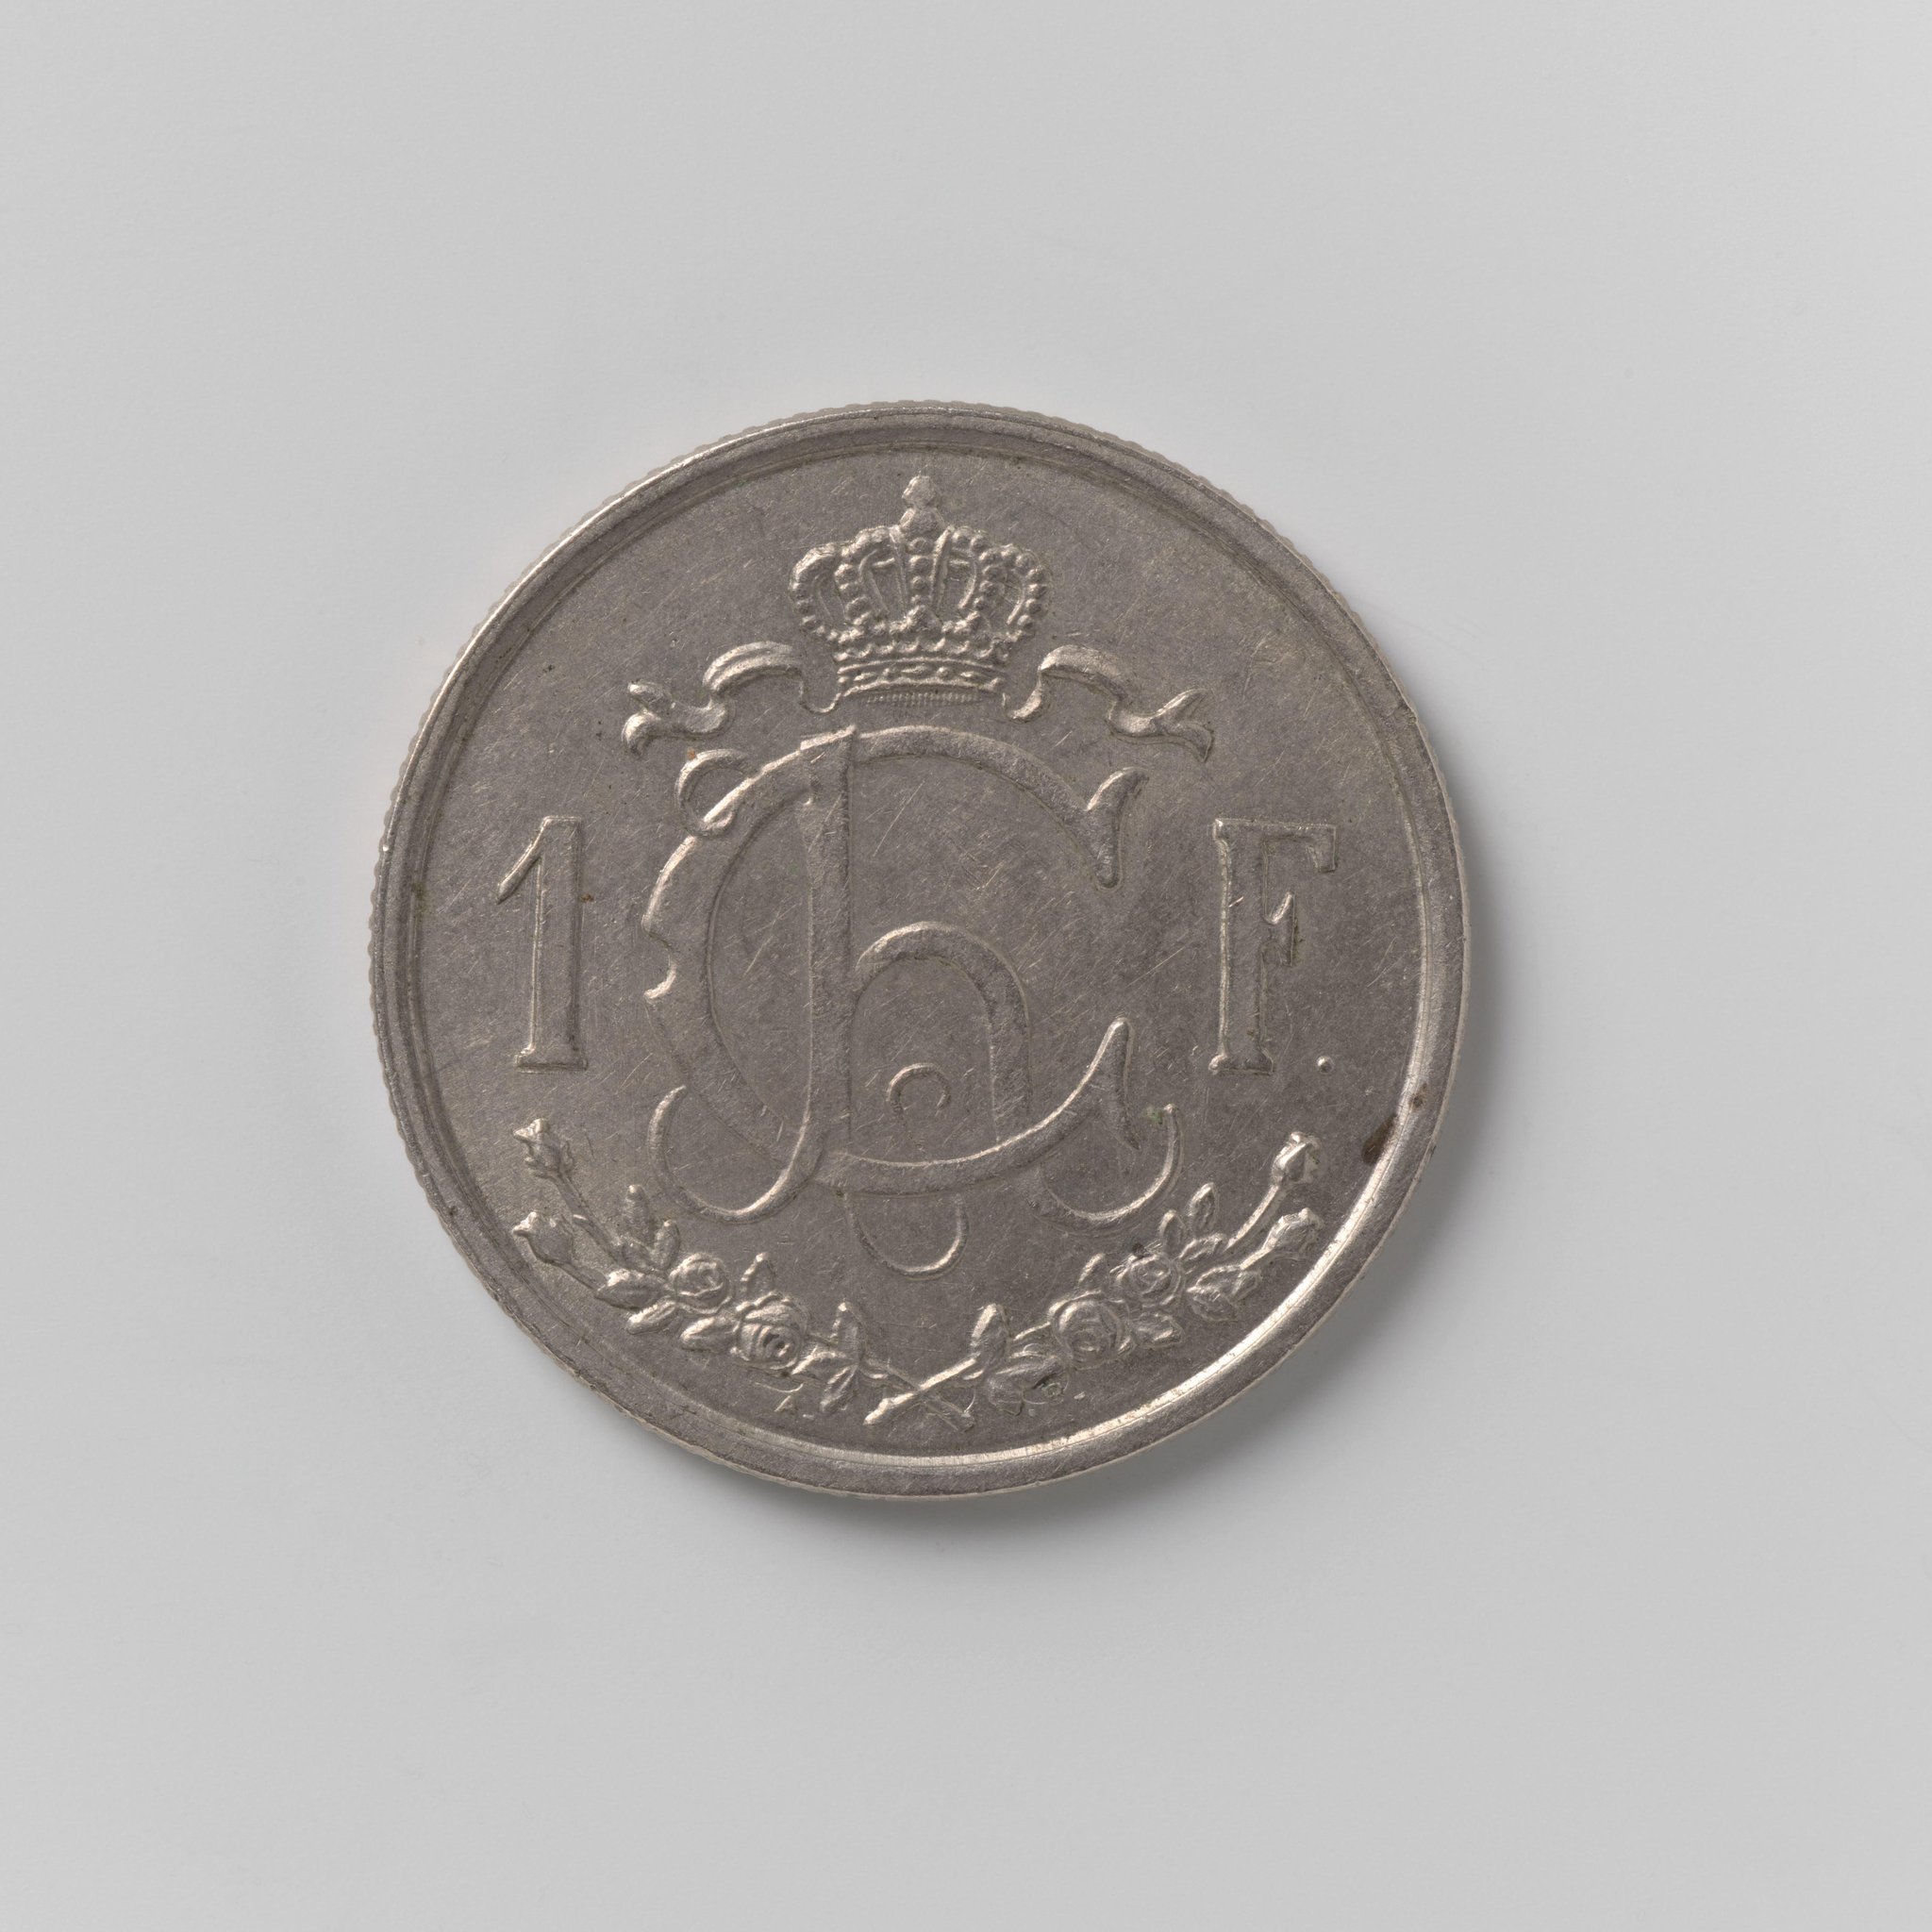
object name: coin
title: Frank uit Luxemburg van Charlotte, 1946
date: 1946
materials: nickel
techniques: striking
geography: brussels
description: Nikkelen munt. Voorzijde: tussen waarde-aanduiding gekroond monogram van de letters C en H. Keerzijde: tegen achtergrond van industriële activiteiten stoker met schep naar rechts. Jaartal in afsnede. Kartelrand.